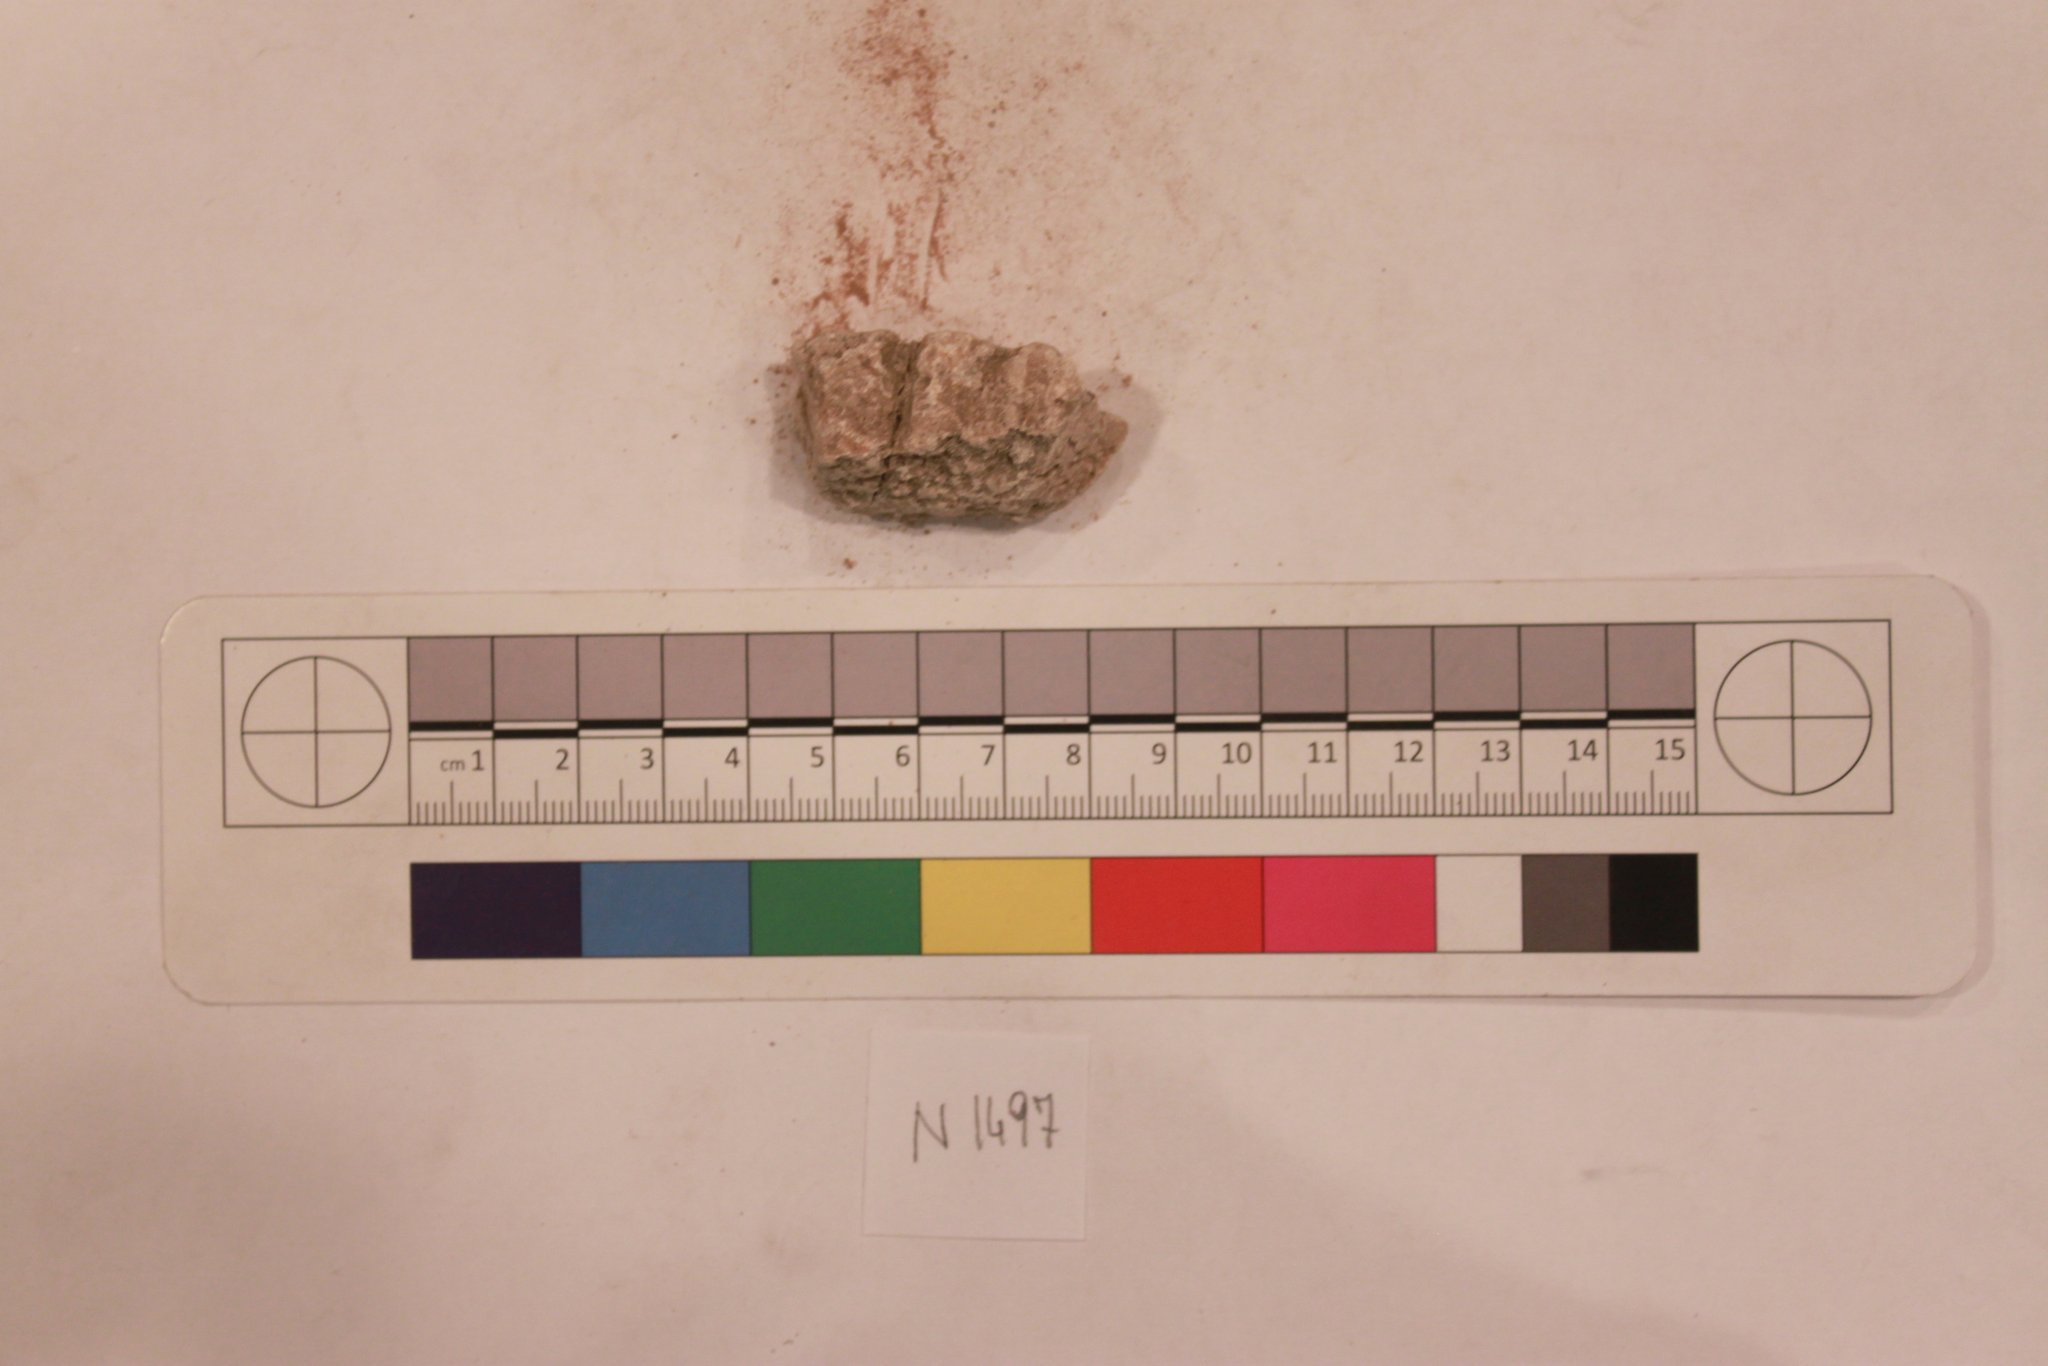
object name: fragment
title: Stucco Fragment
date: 701-1200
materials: plaster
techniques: carving, painting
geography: iran